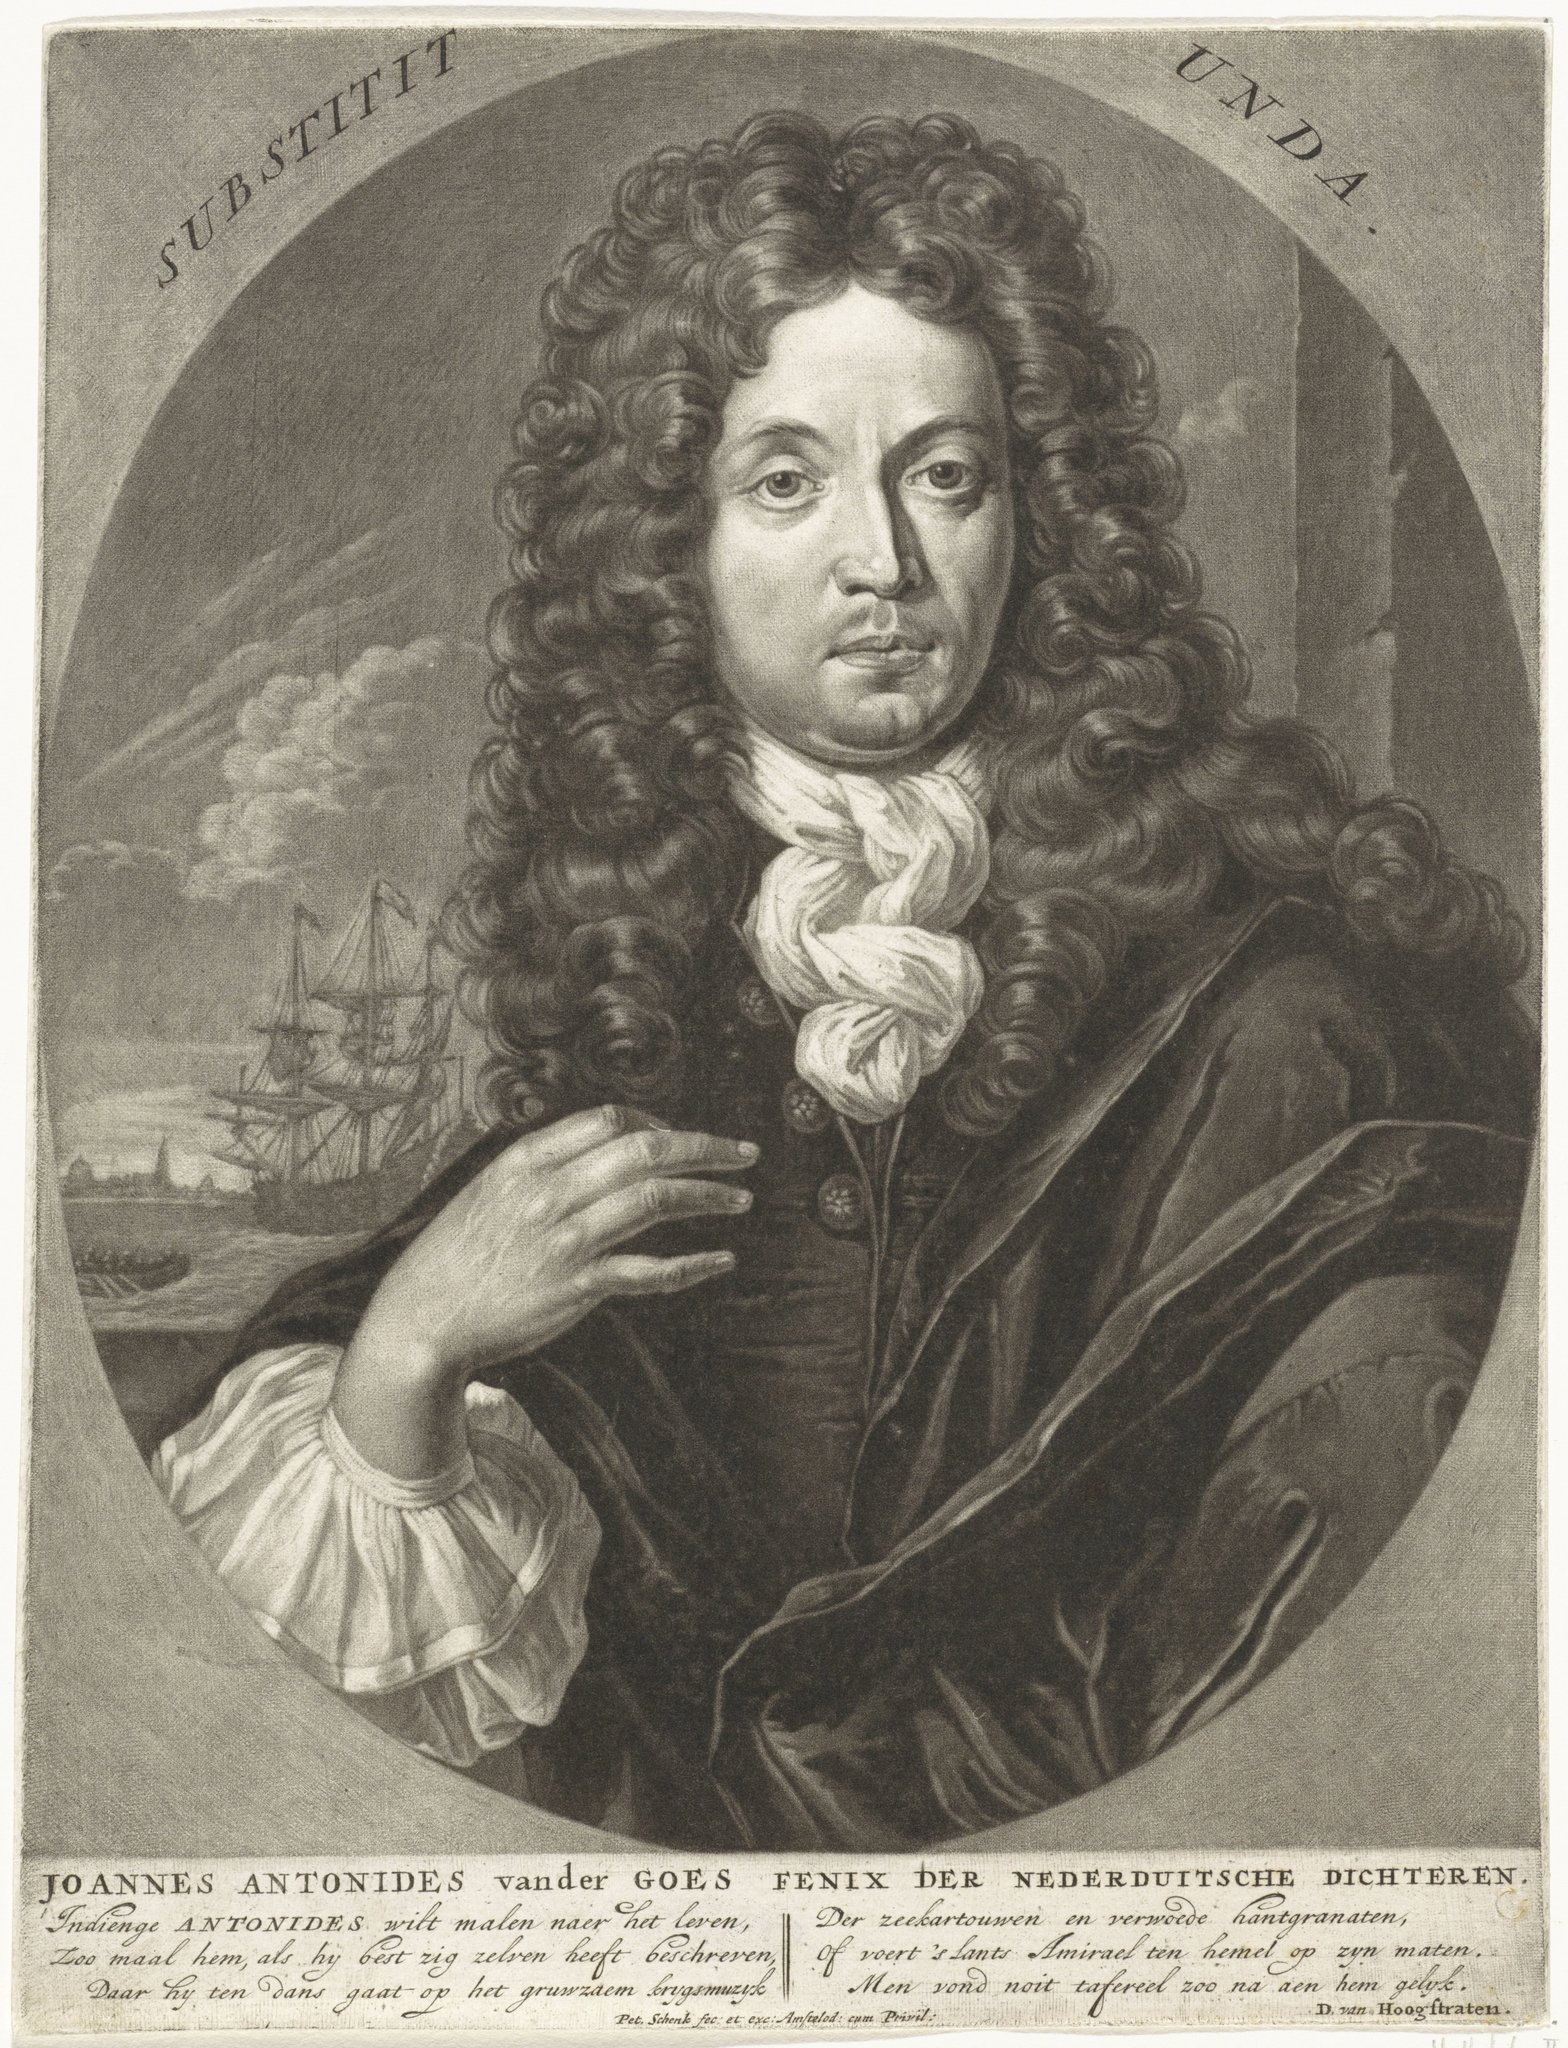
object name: print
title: Portret van Jan Antonides van der Goes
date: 1670-1713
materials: paper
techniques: engraving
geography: amsterdam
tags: jan antonides van der goes, sailing-ship, sailing-boat, portrait of a writer, wig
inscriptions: collector's mark: Lugt 2228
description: Jan Antonides van der Goes, Amsterdamse dichter, toneelvertaler en toneelschrijver. Hij draagt een pruik. Op de achtergrond een schip.